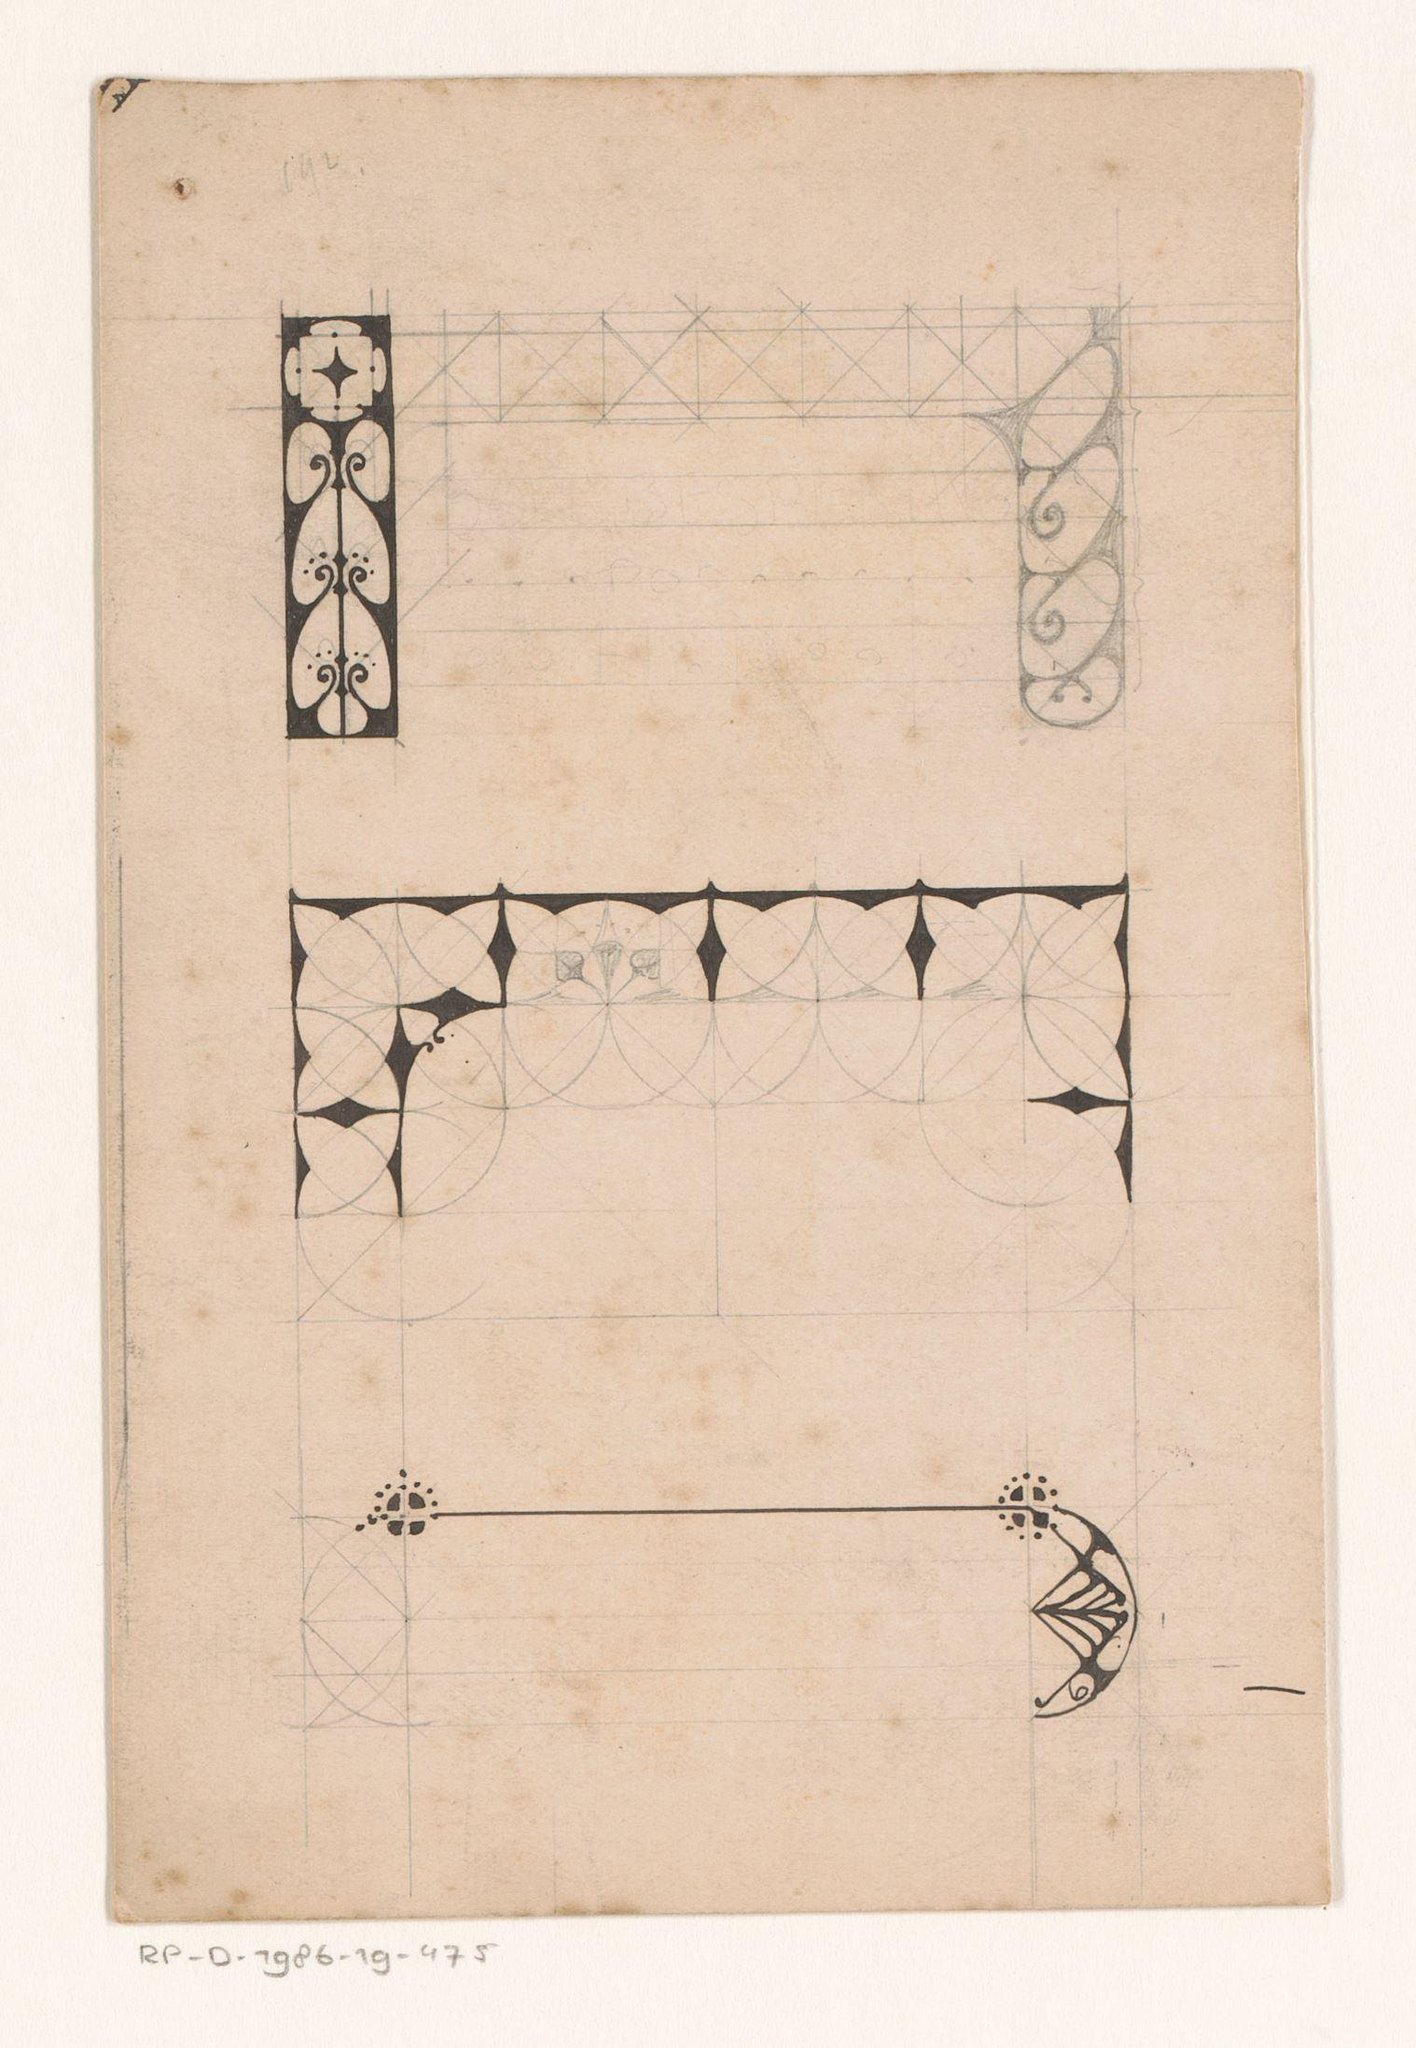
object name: drawing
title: Ontwerpen voor kaders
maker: reinier willem petrus de vries (1874-1953)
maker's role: draughtsman, print maker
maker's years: 1874-1953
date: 1884-1952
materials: ink, paper, pencil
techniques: pen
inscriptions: collector's mark: ‘R:MVS.’